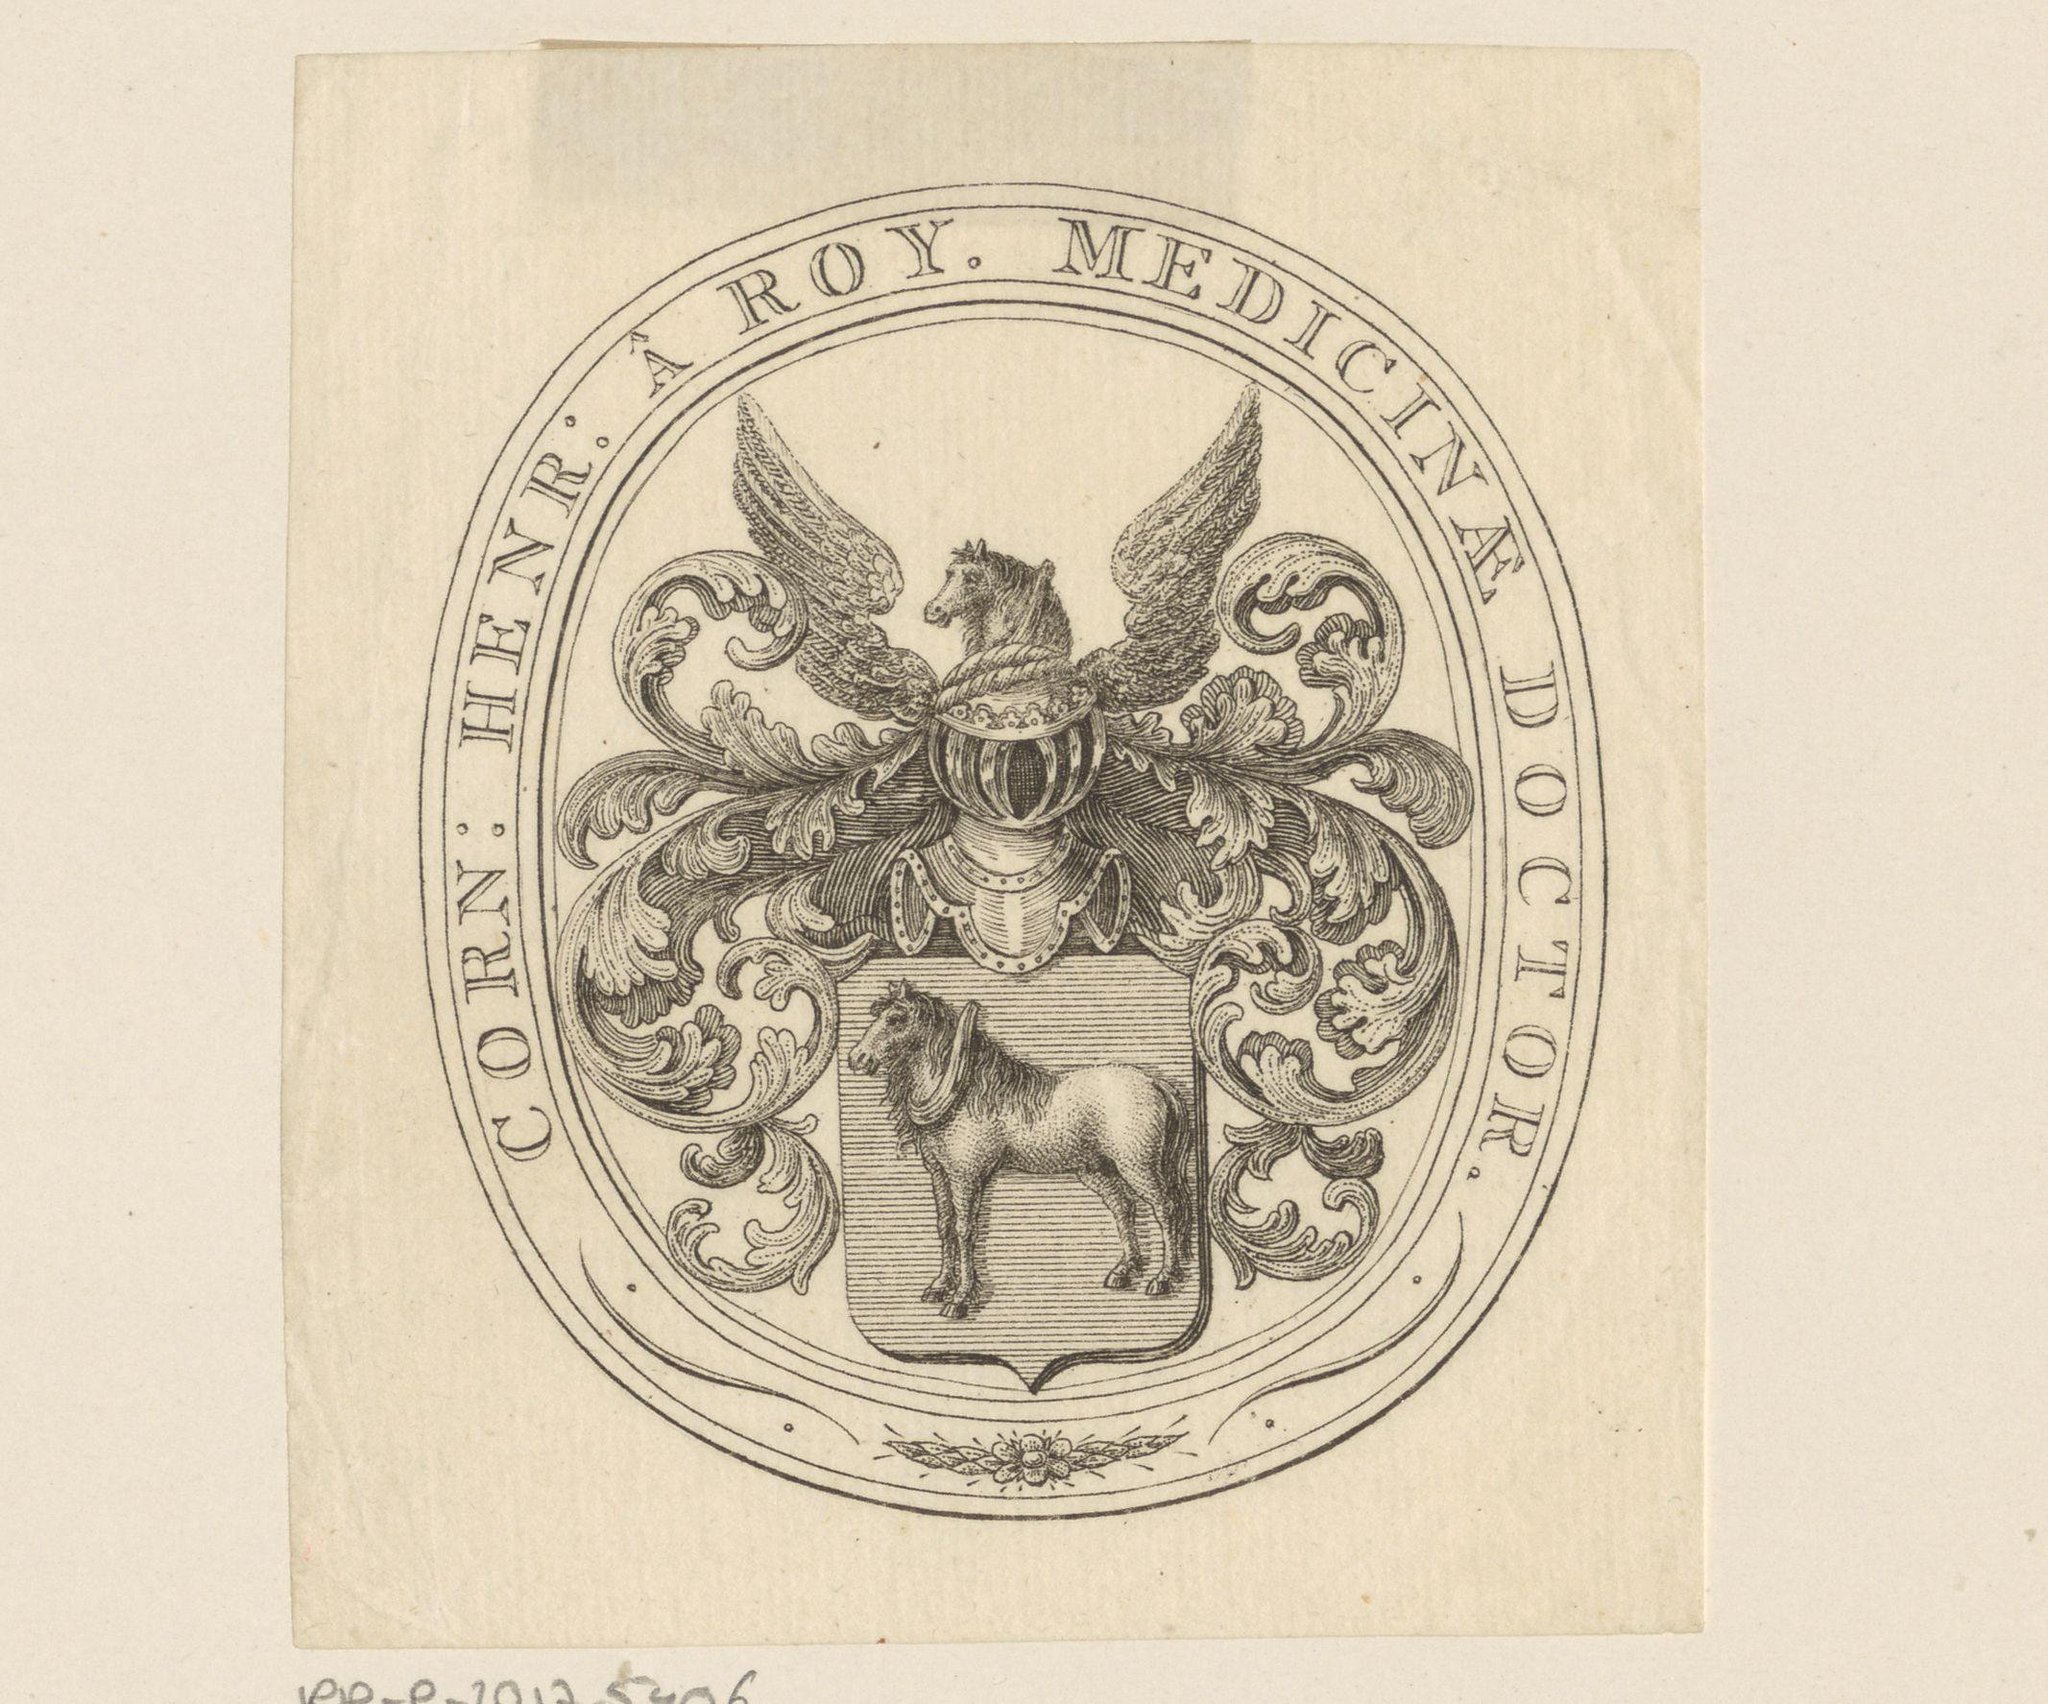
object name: bookplate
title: Corn: Henr: â Roy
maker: Anonymous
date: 1760-1833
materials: paper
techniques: etching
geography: netherlands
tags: horse, armorial bearing, heraldry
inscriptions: inscription: ‘Rietstap, 2, 624’